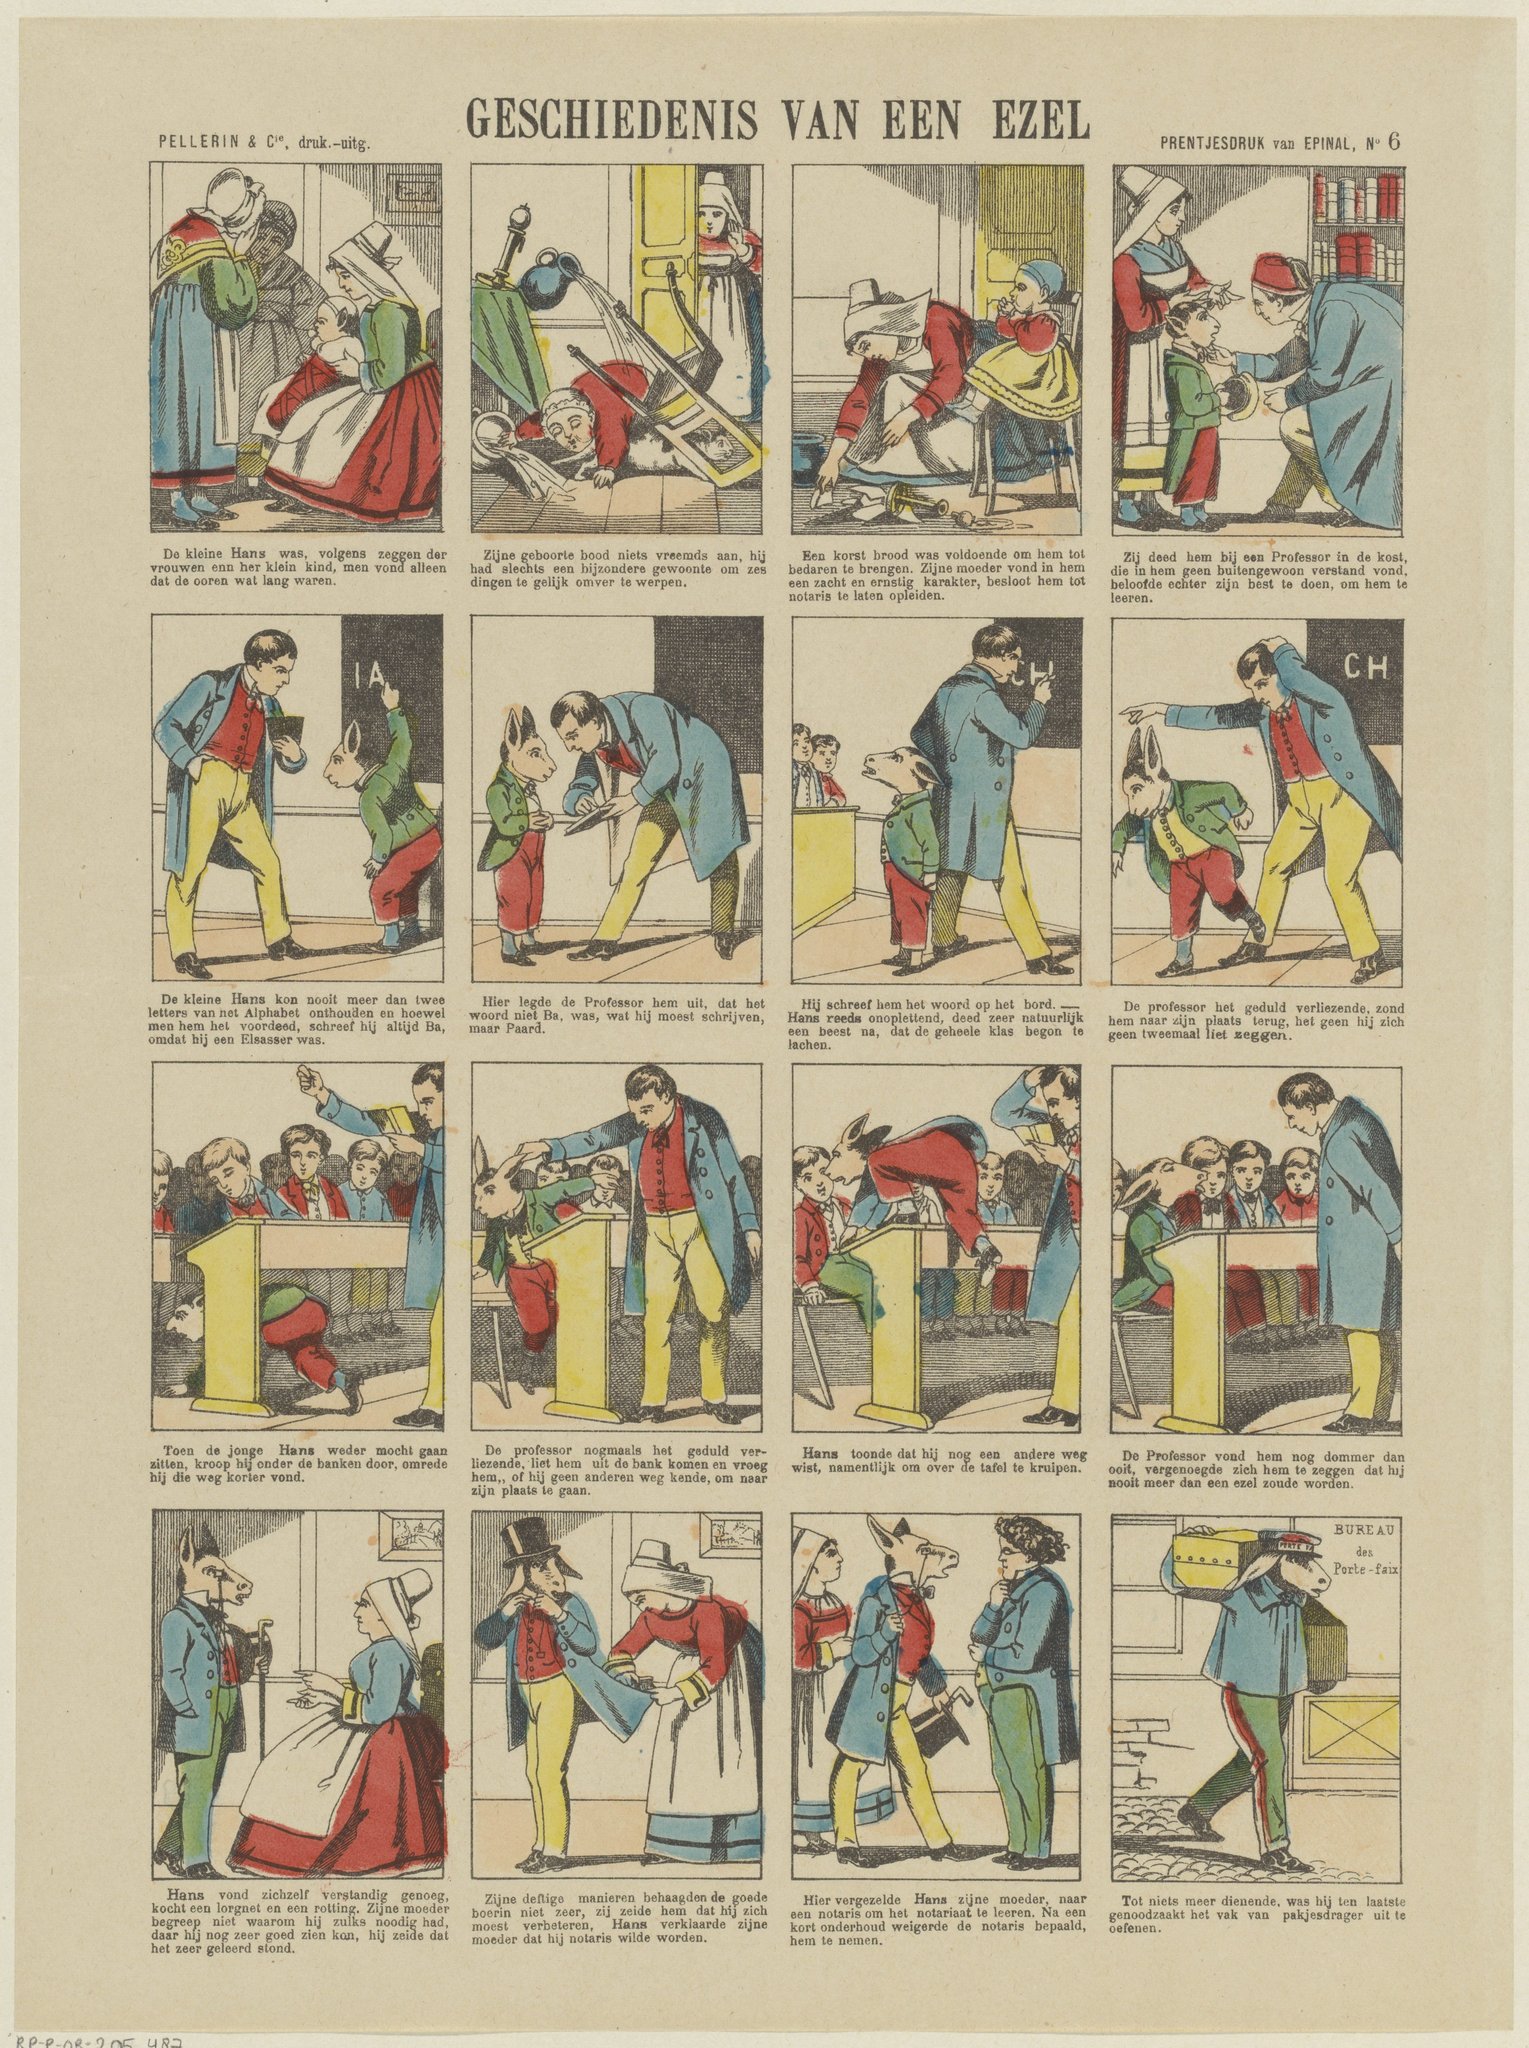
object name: print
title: Prentjesdruk van Épinal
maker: Anonymous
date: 1902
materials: paper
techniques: colour, letterpress printing, lithograph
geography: epinal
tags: horses and kindred animals, tales and fairy tales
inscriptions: collector's mark: Lugt 2760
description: Blad met 16 voorstellingen over het jongetje Hans, dat geboren wordt met een ezelskop. Onder elke afbeelding een onderschrift. Genummerd rechtsboven: No 6.